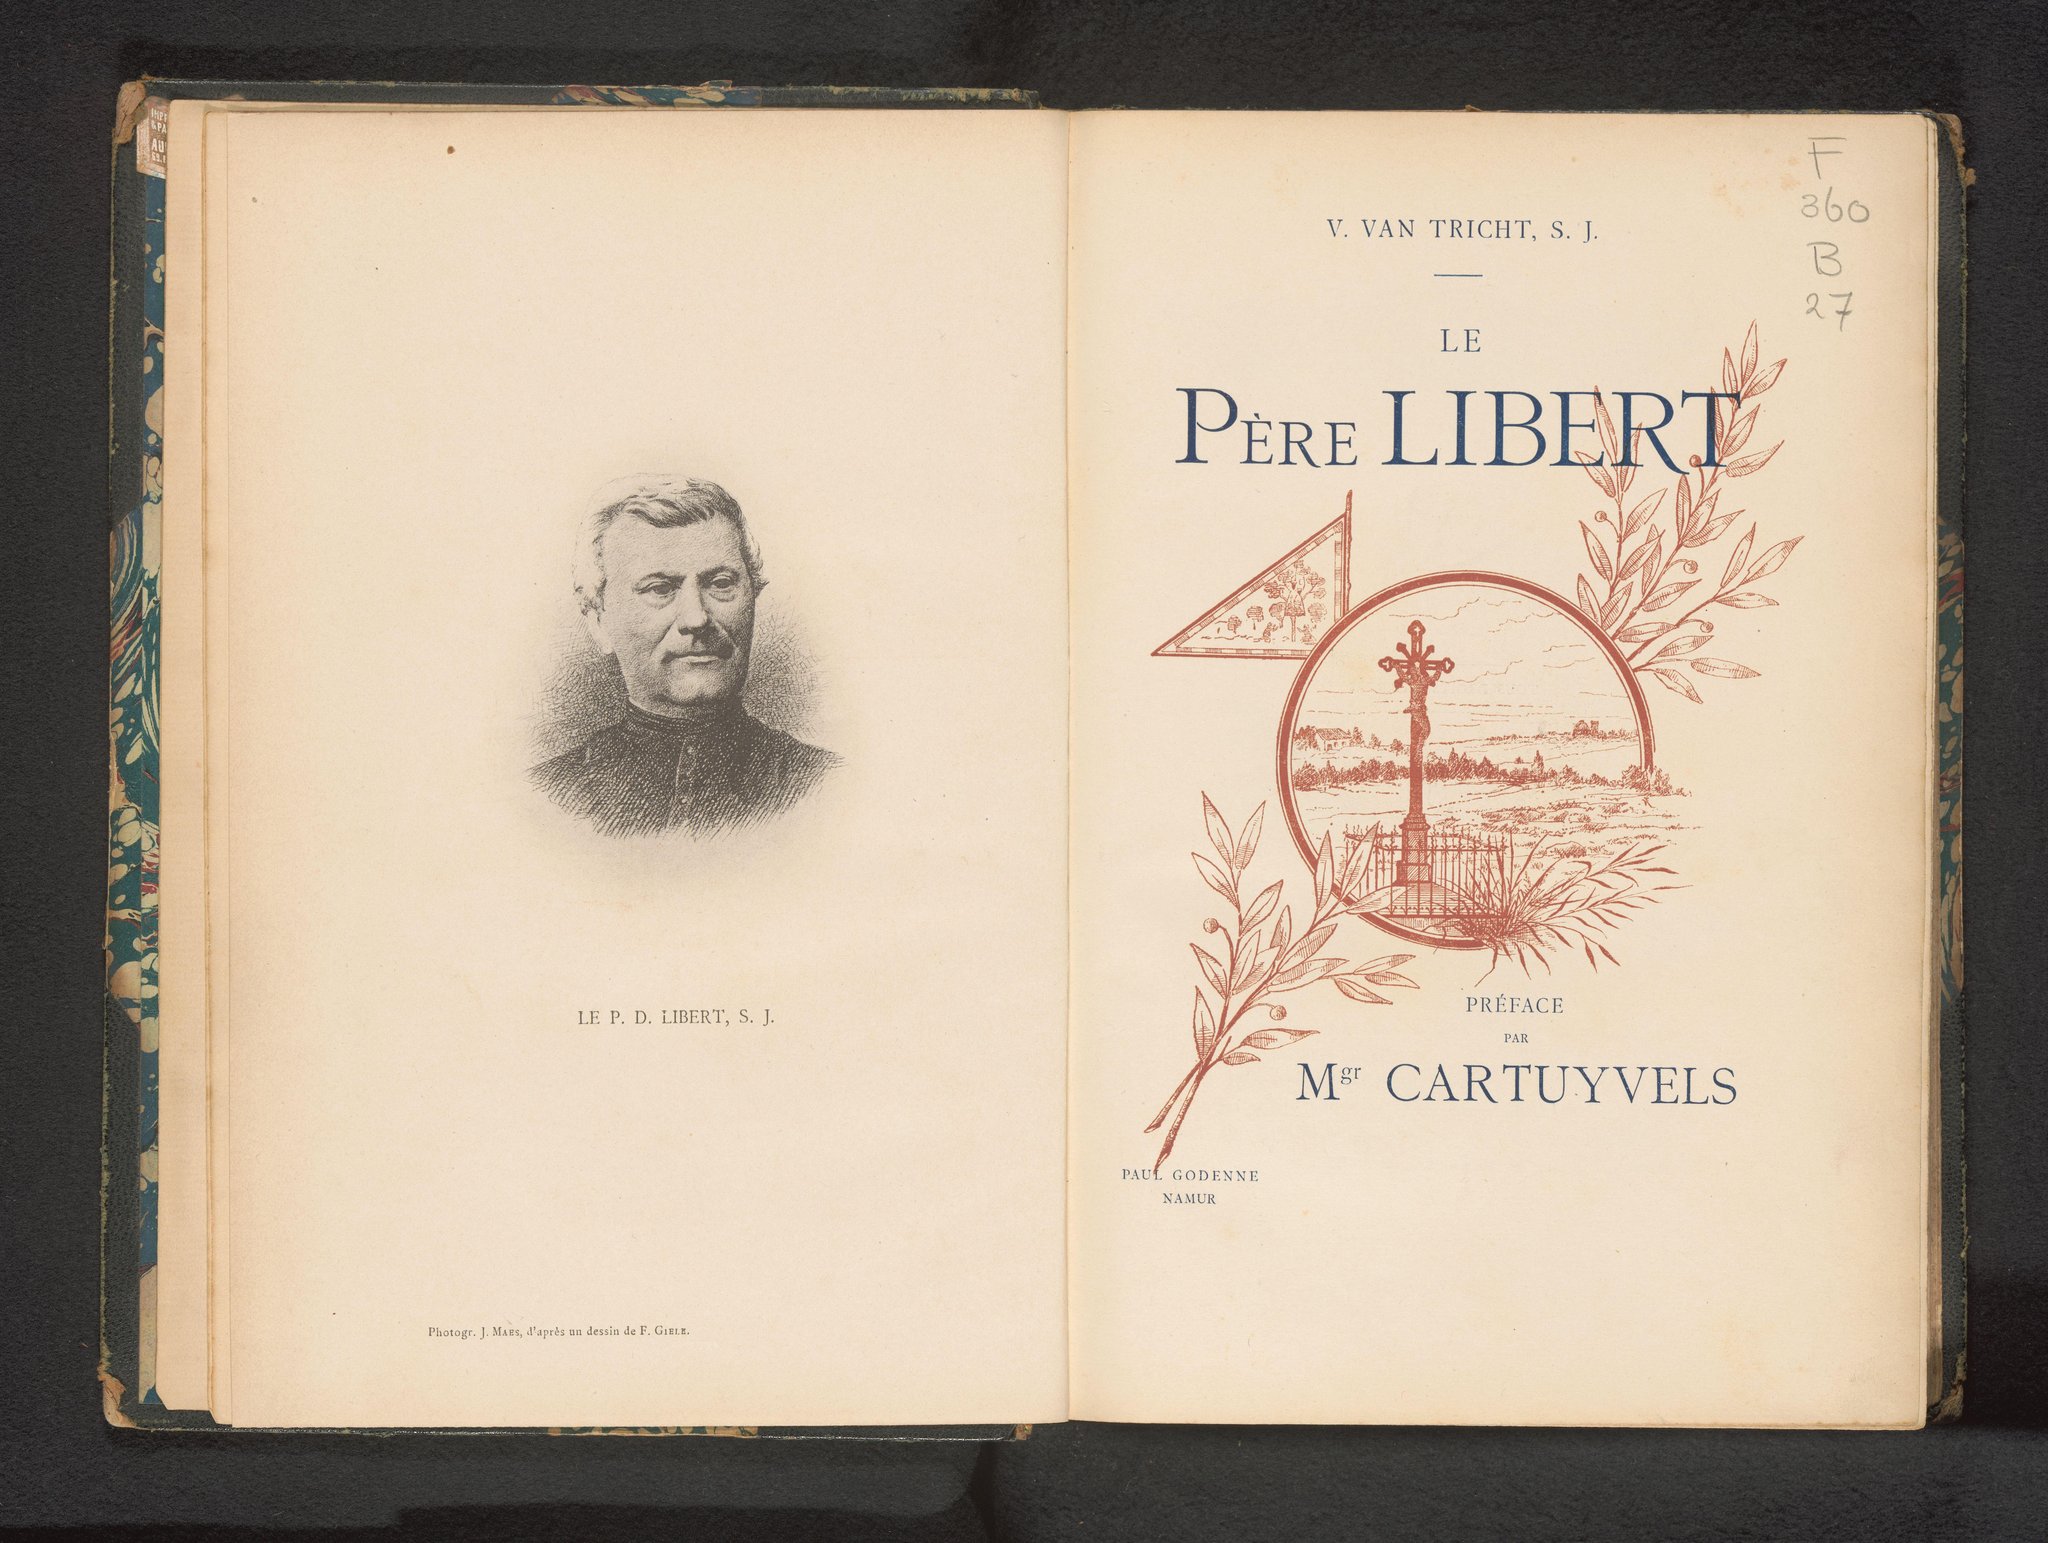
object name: photomechanical print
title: Le P. D. Libert, S. J.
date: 1891-1896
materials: paper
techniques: photograph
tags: historical persons